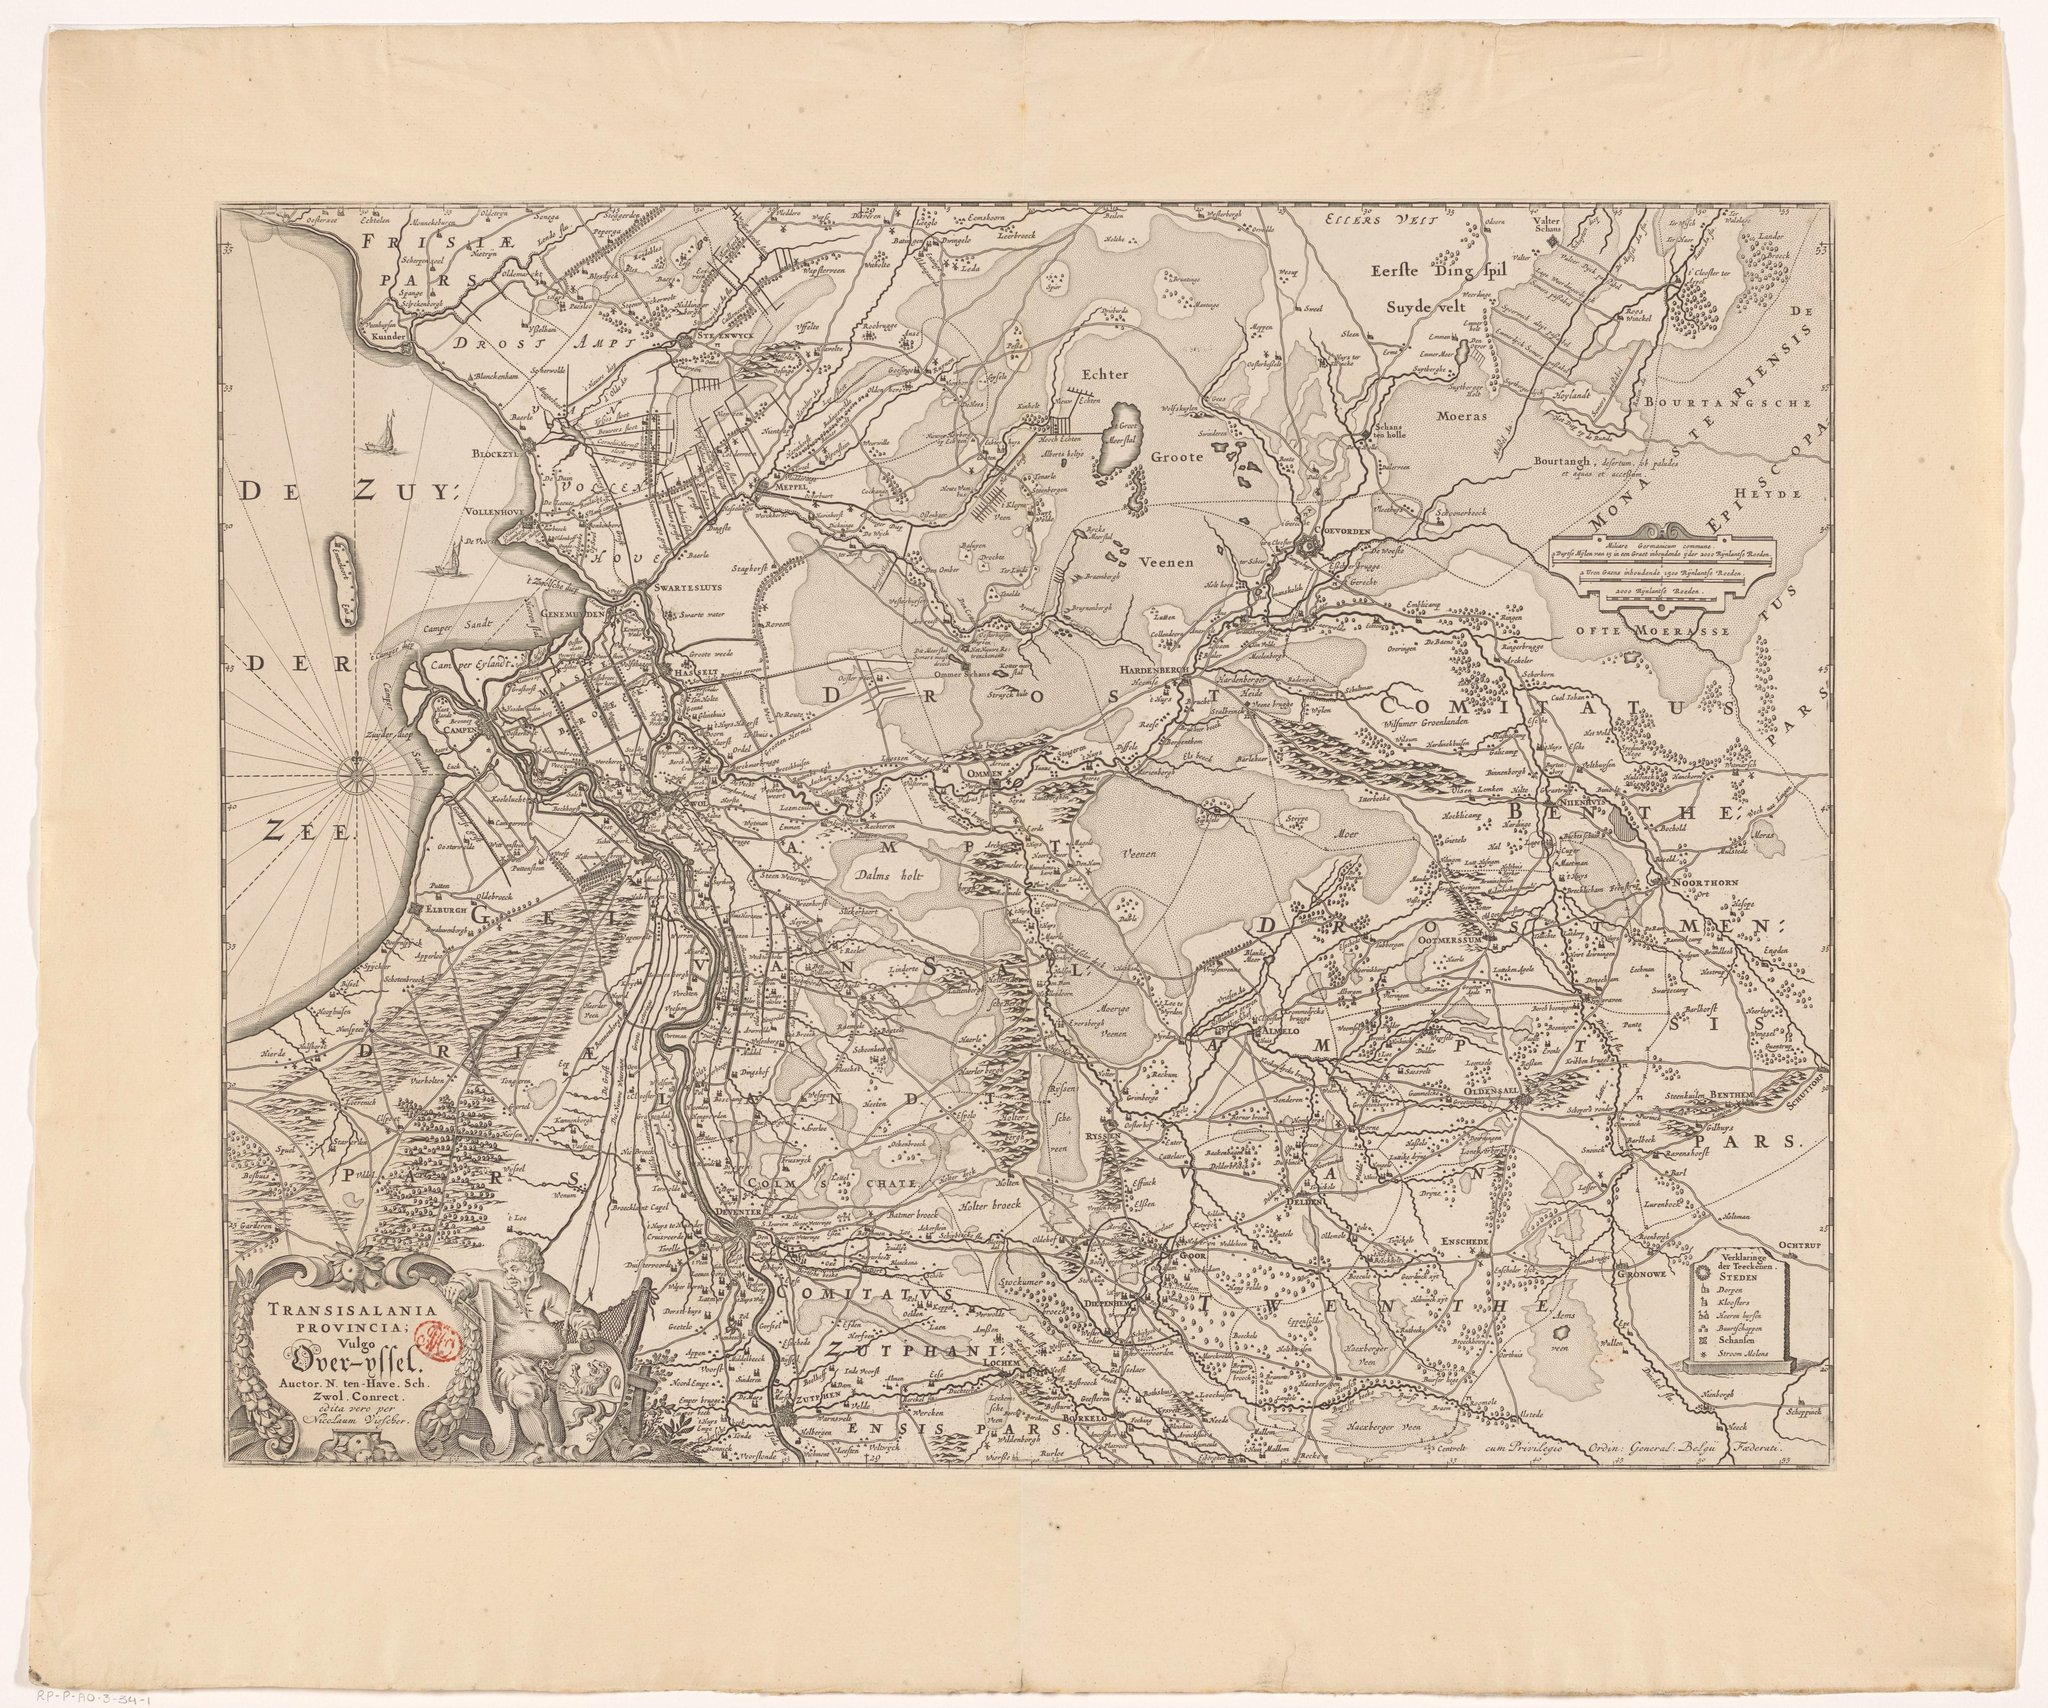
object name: print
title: Transisalania provincia; vulgo Over-yssel (...)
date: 1640-1652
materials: paper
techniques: engraving, etching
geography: zwolle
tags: coat of arms (as symbol of the state, etc.), maps of separate countries or regions, fisherman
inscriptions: collector's mark: Lugt 195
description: Linksonder de titelcartouche, daarnaast een visser en het wapen van Overijssel. Rechtsboven drie schaalstokken: Miliare Germanicum commune / 2 Duytse mijlen van 15 in een graet inhoudende ijder 2000 Rijnlantse roeden, 2 uren gaens inhoudende 1500 Rijnlantse roeden, 2000 Rijnlantse roeden. Rechtsonder een legenda. Gradenverdeling langs de randen.